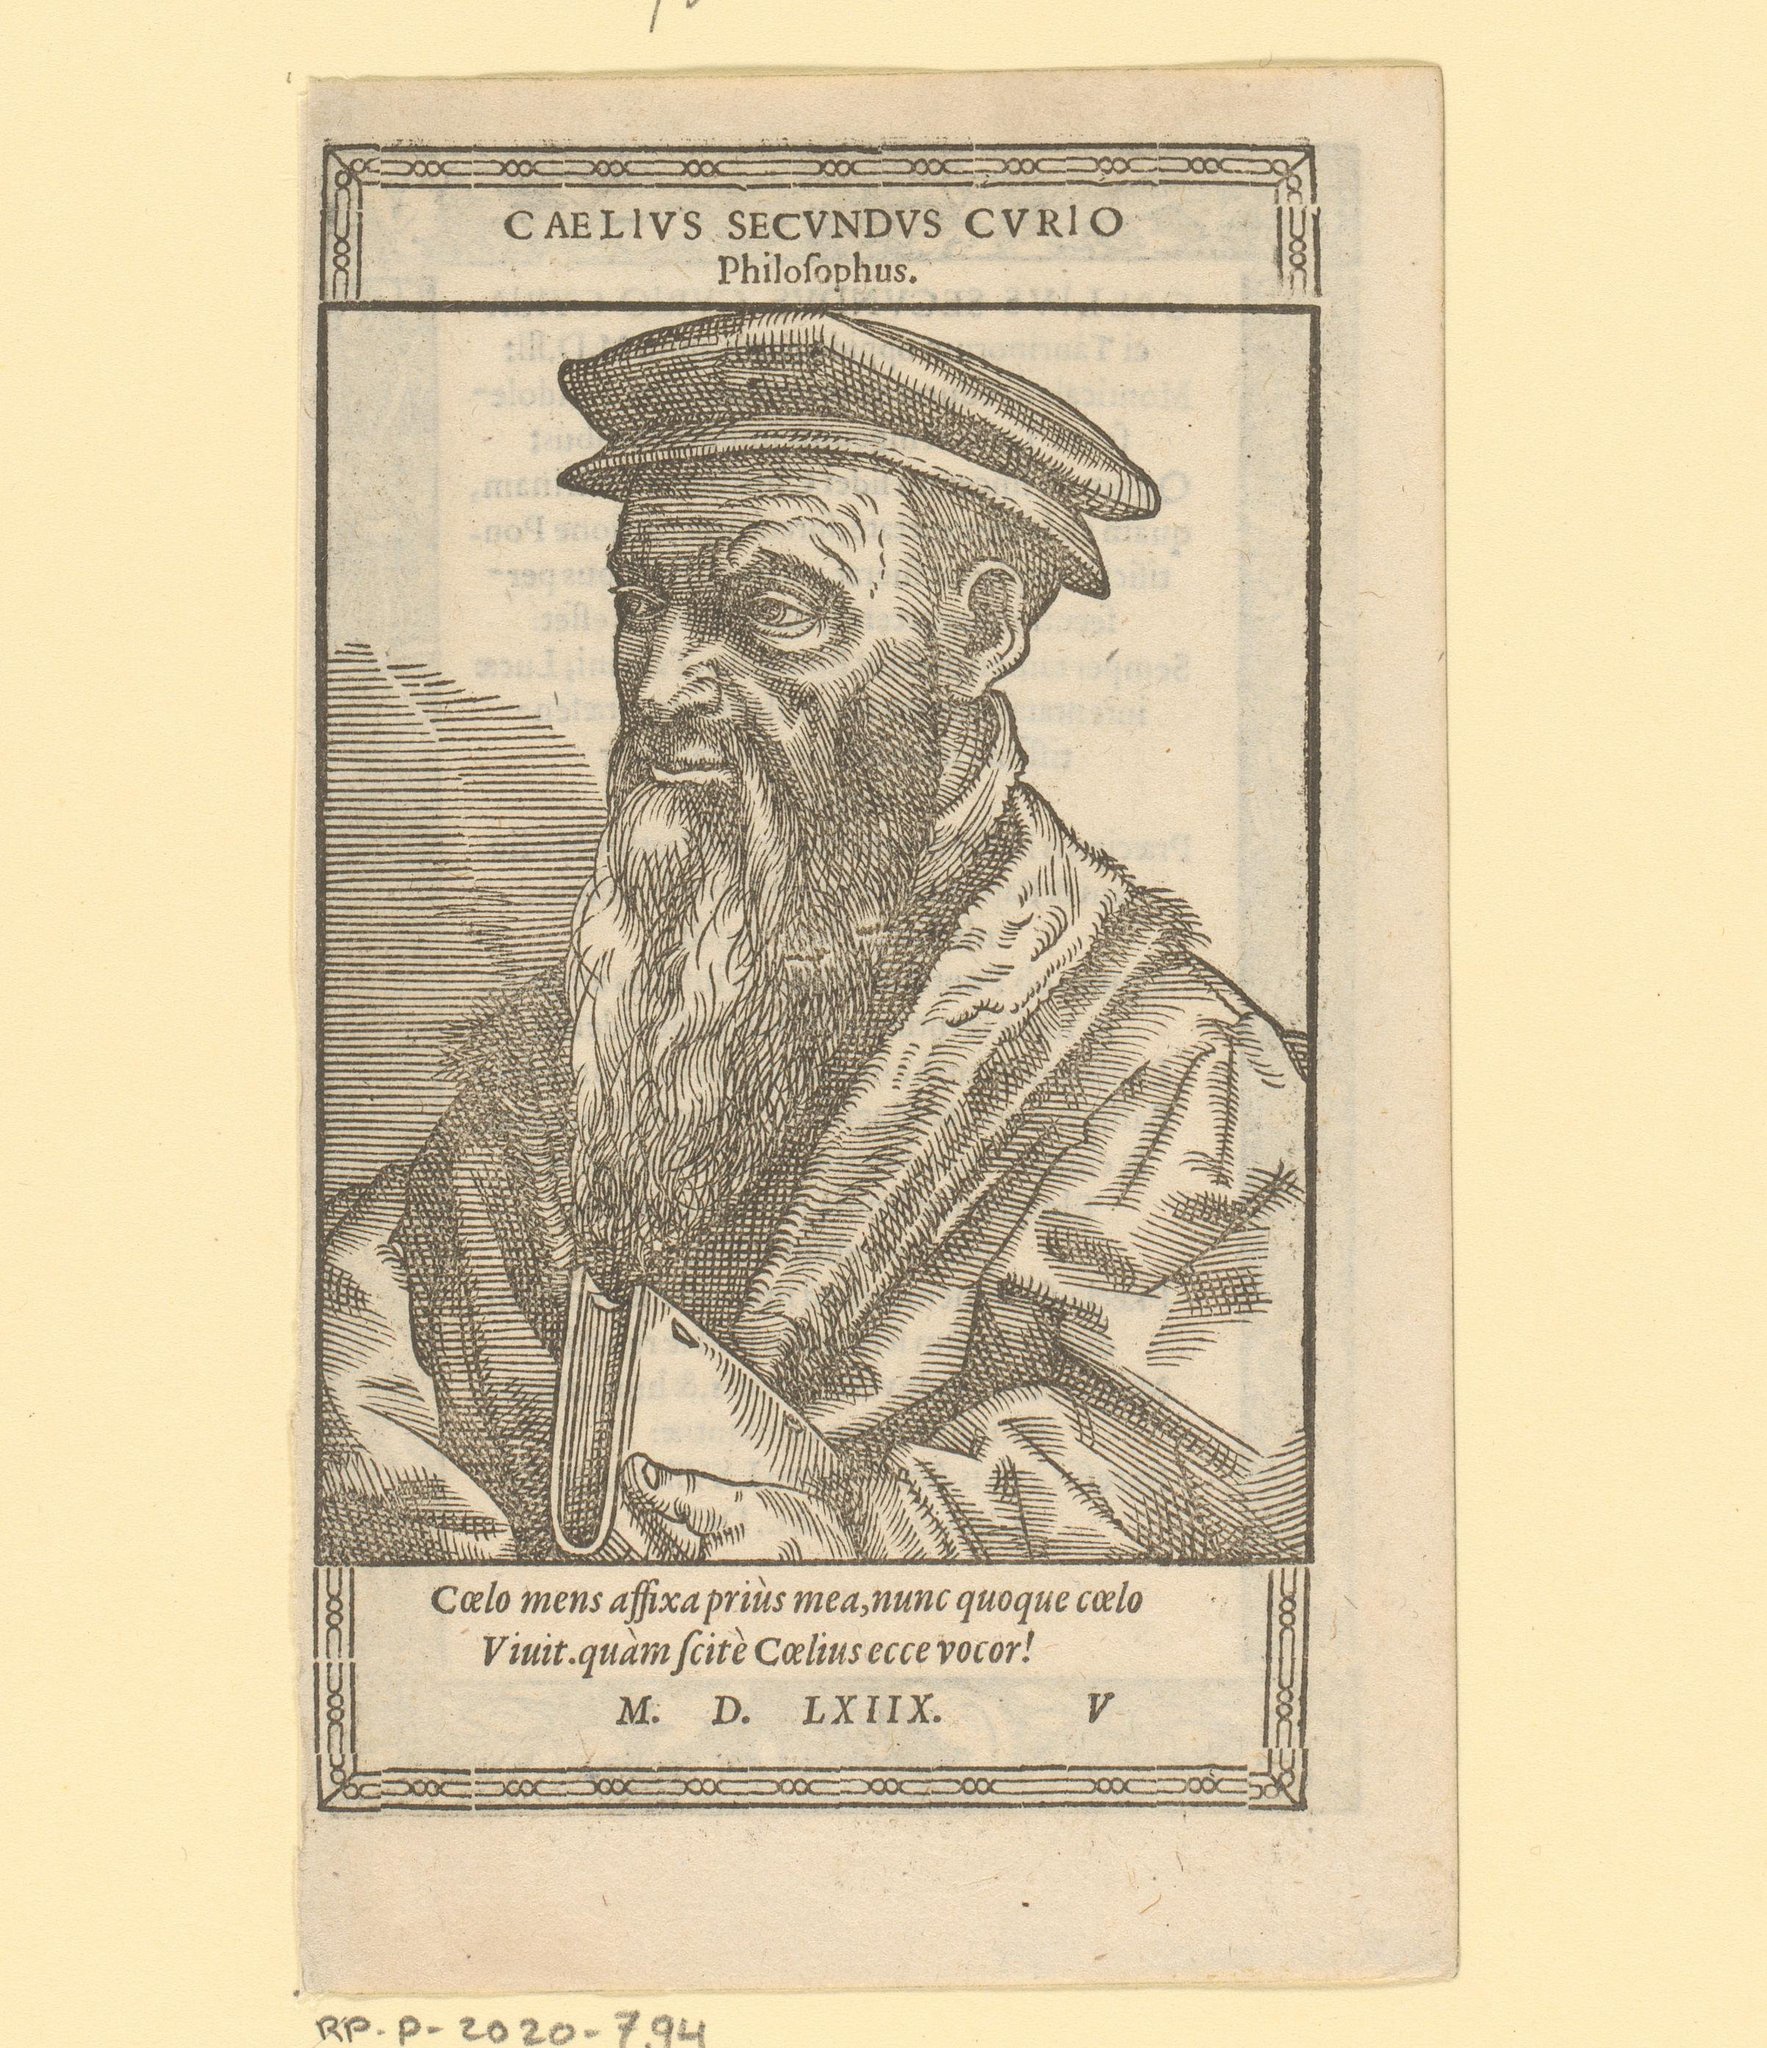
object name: print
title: Portret van Celio Secundo Curione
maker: bernhard jobin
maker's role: printer, publisher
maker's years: 1545-1593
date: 1587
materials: paper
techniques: letterpress printing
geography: straatsburg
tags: scholar, philosopher, historical persons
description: Prent uit: Reusner, Nikolaus. Icones sive imagines virorum literis illustrium (...). Straatsburg: Bernhard Jobin, 1587. Prent ook gebruikt in de Duitse editie, uitgegeven in hetzelfde jaar, en de 1590-editie. Prent ook gebruikt in latere publicaties.